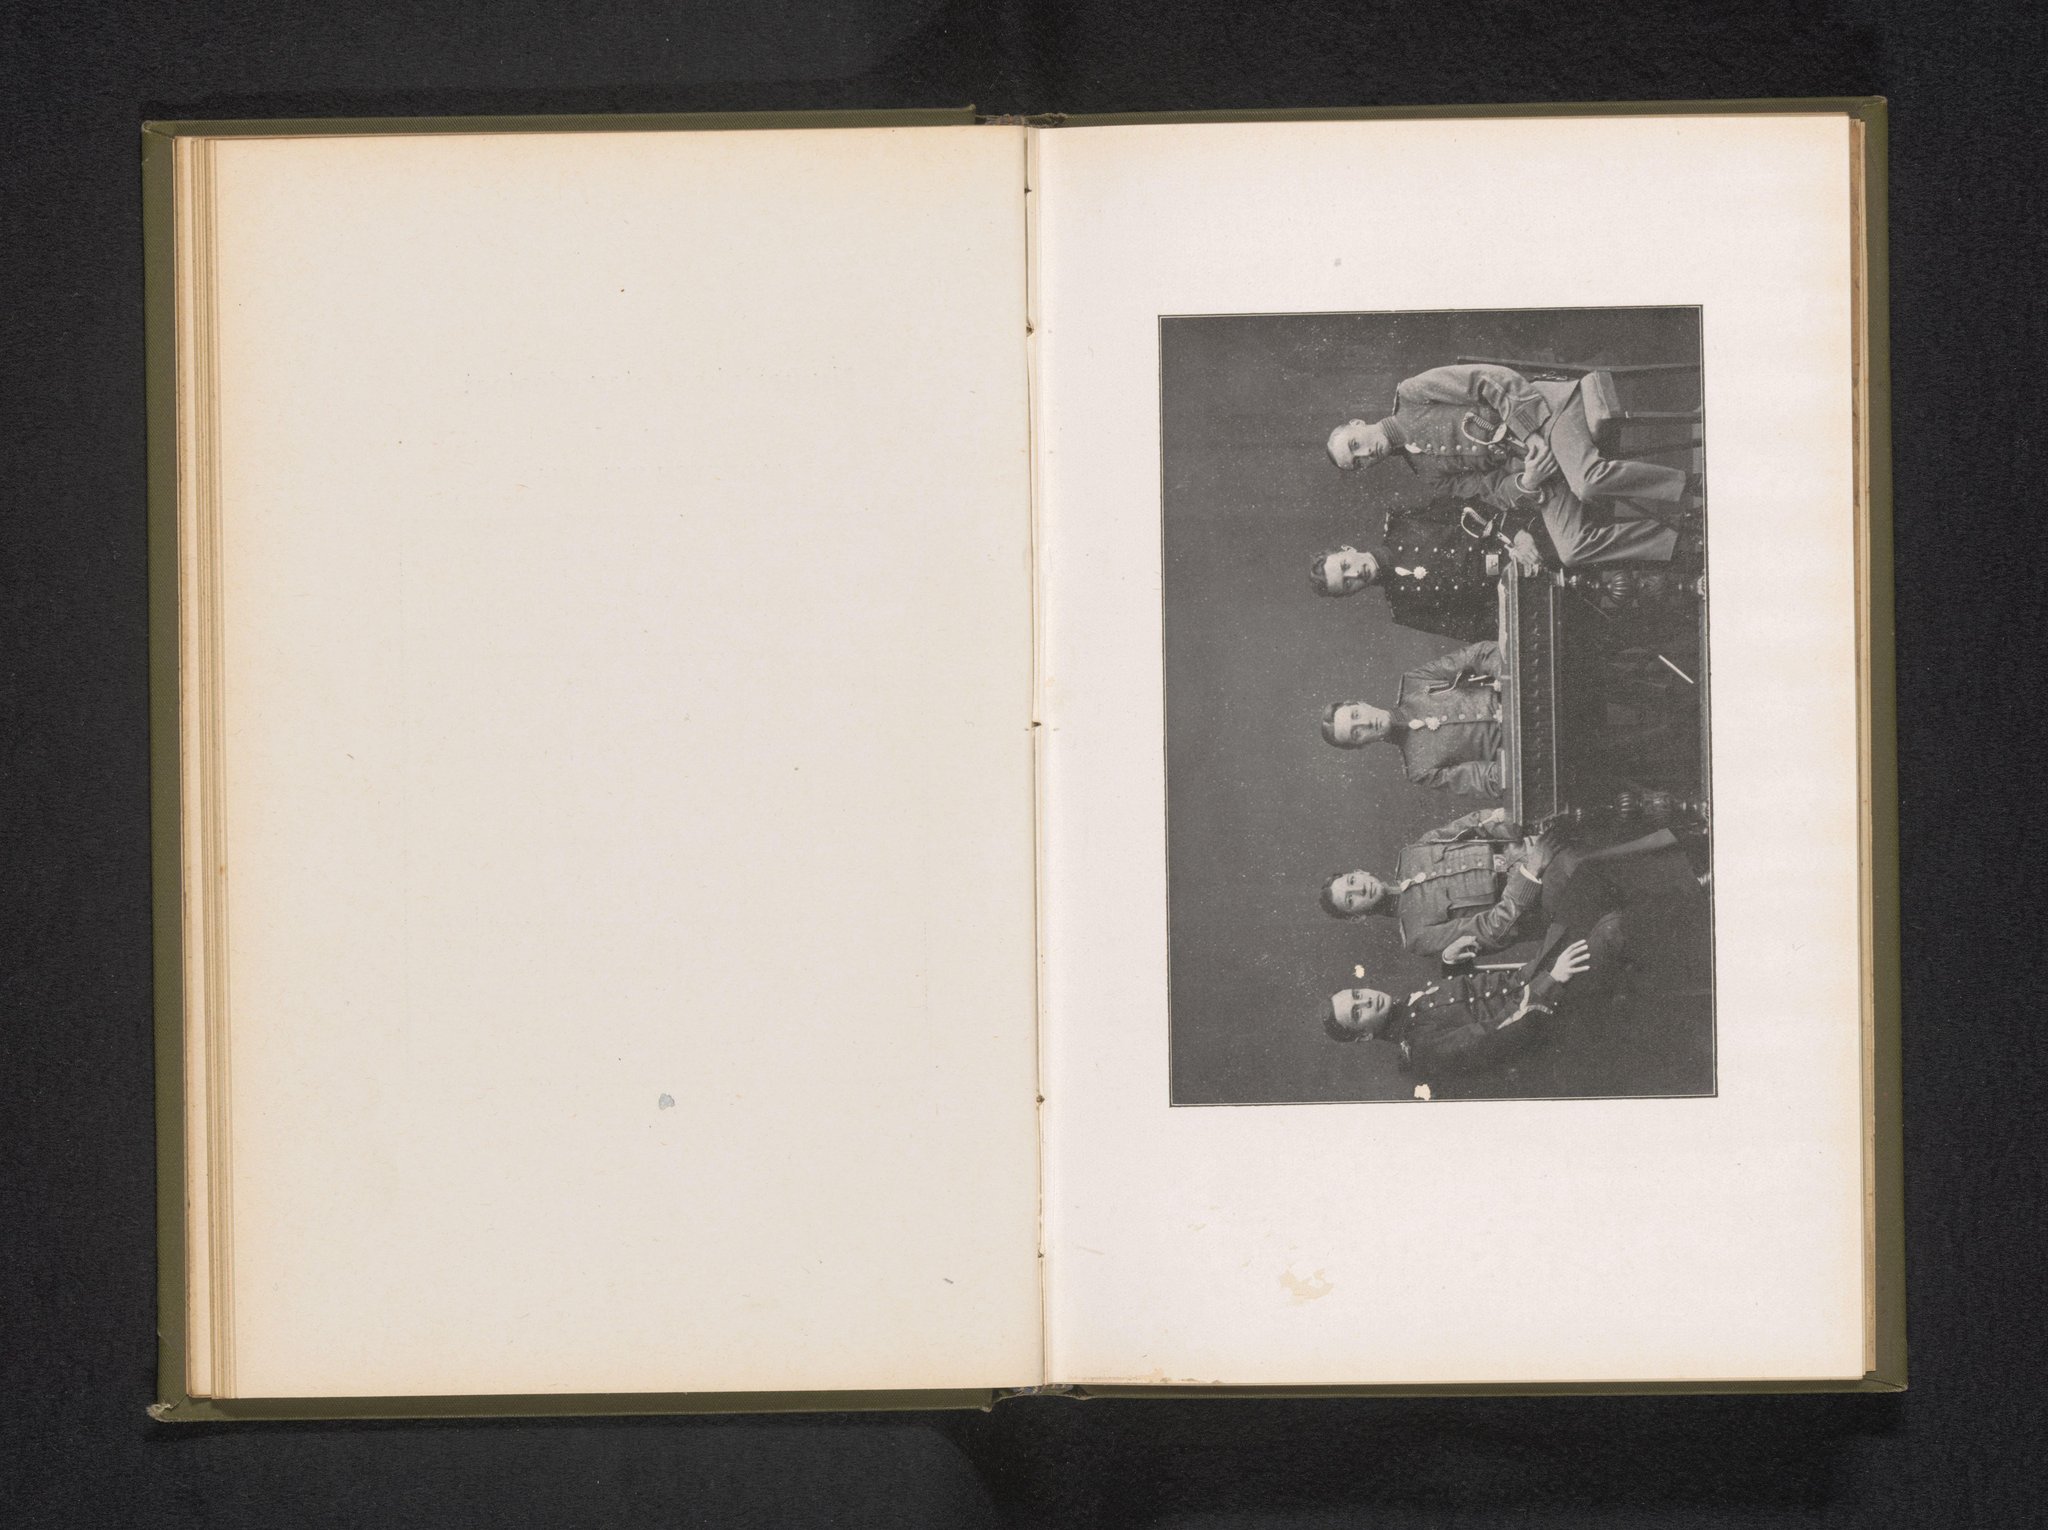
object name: photomechanical print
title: Groepsportret van de Senaat van het cadettenkorps van de Koninklijke Militaire Academie in Breda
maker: Anonymous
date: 1911-1916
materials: paper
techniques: autotype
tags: anonymous historical persons portrayed in a group, in a group-portrait